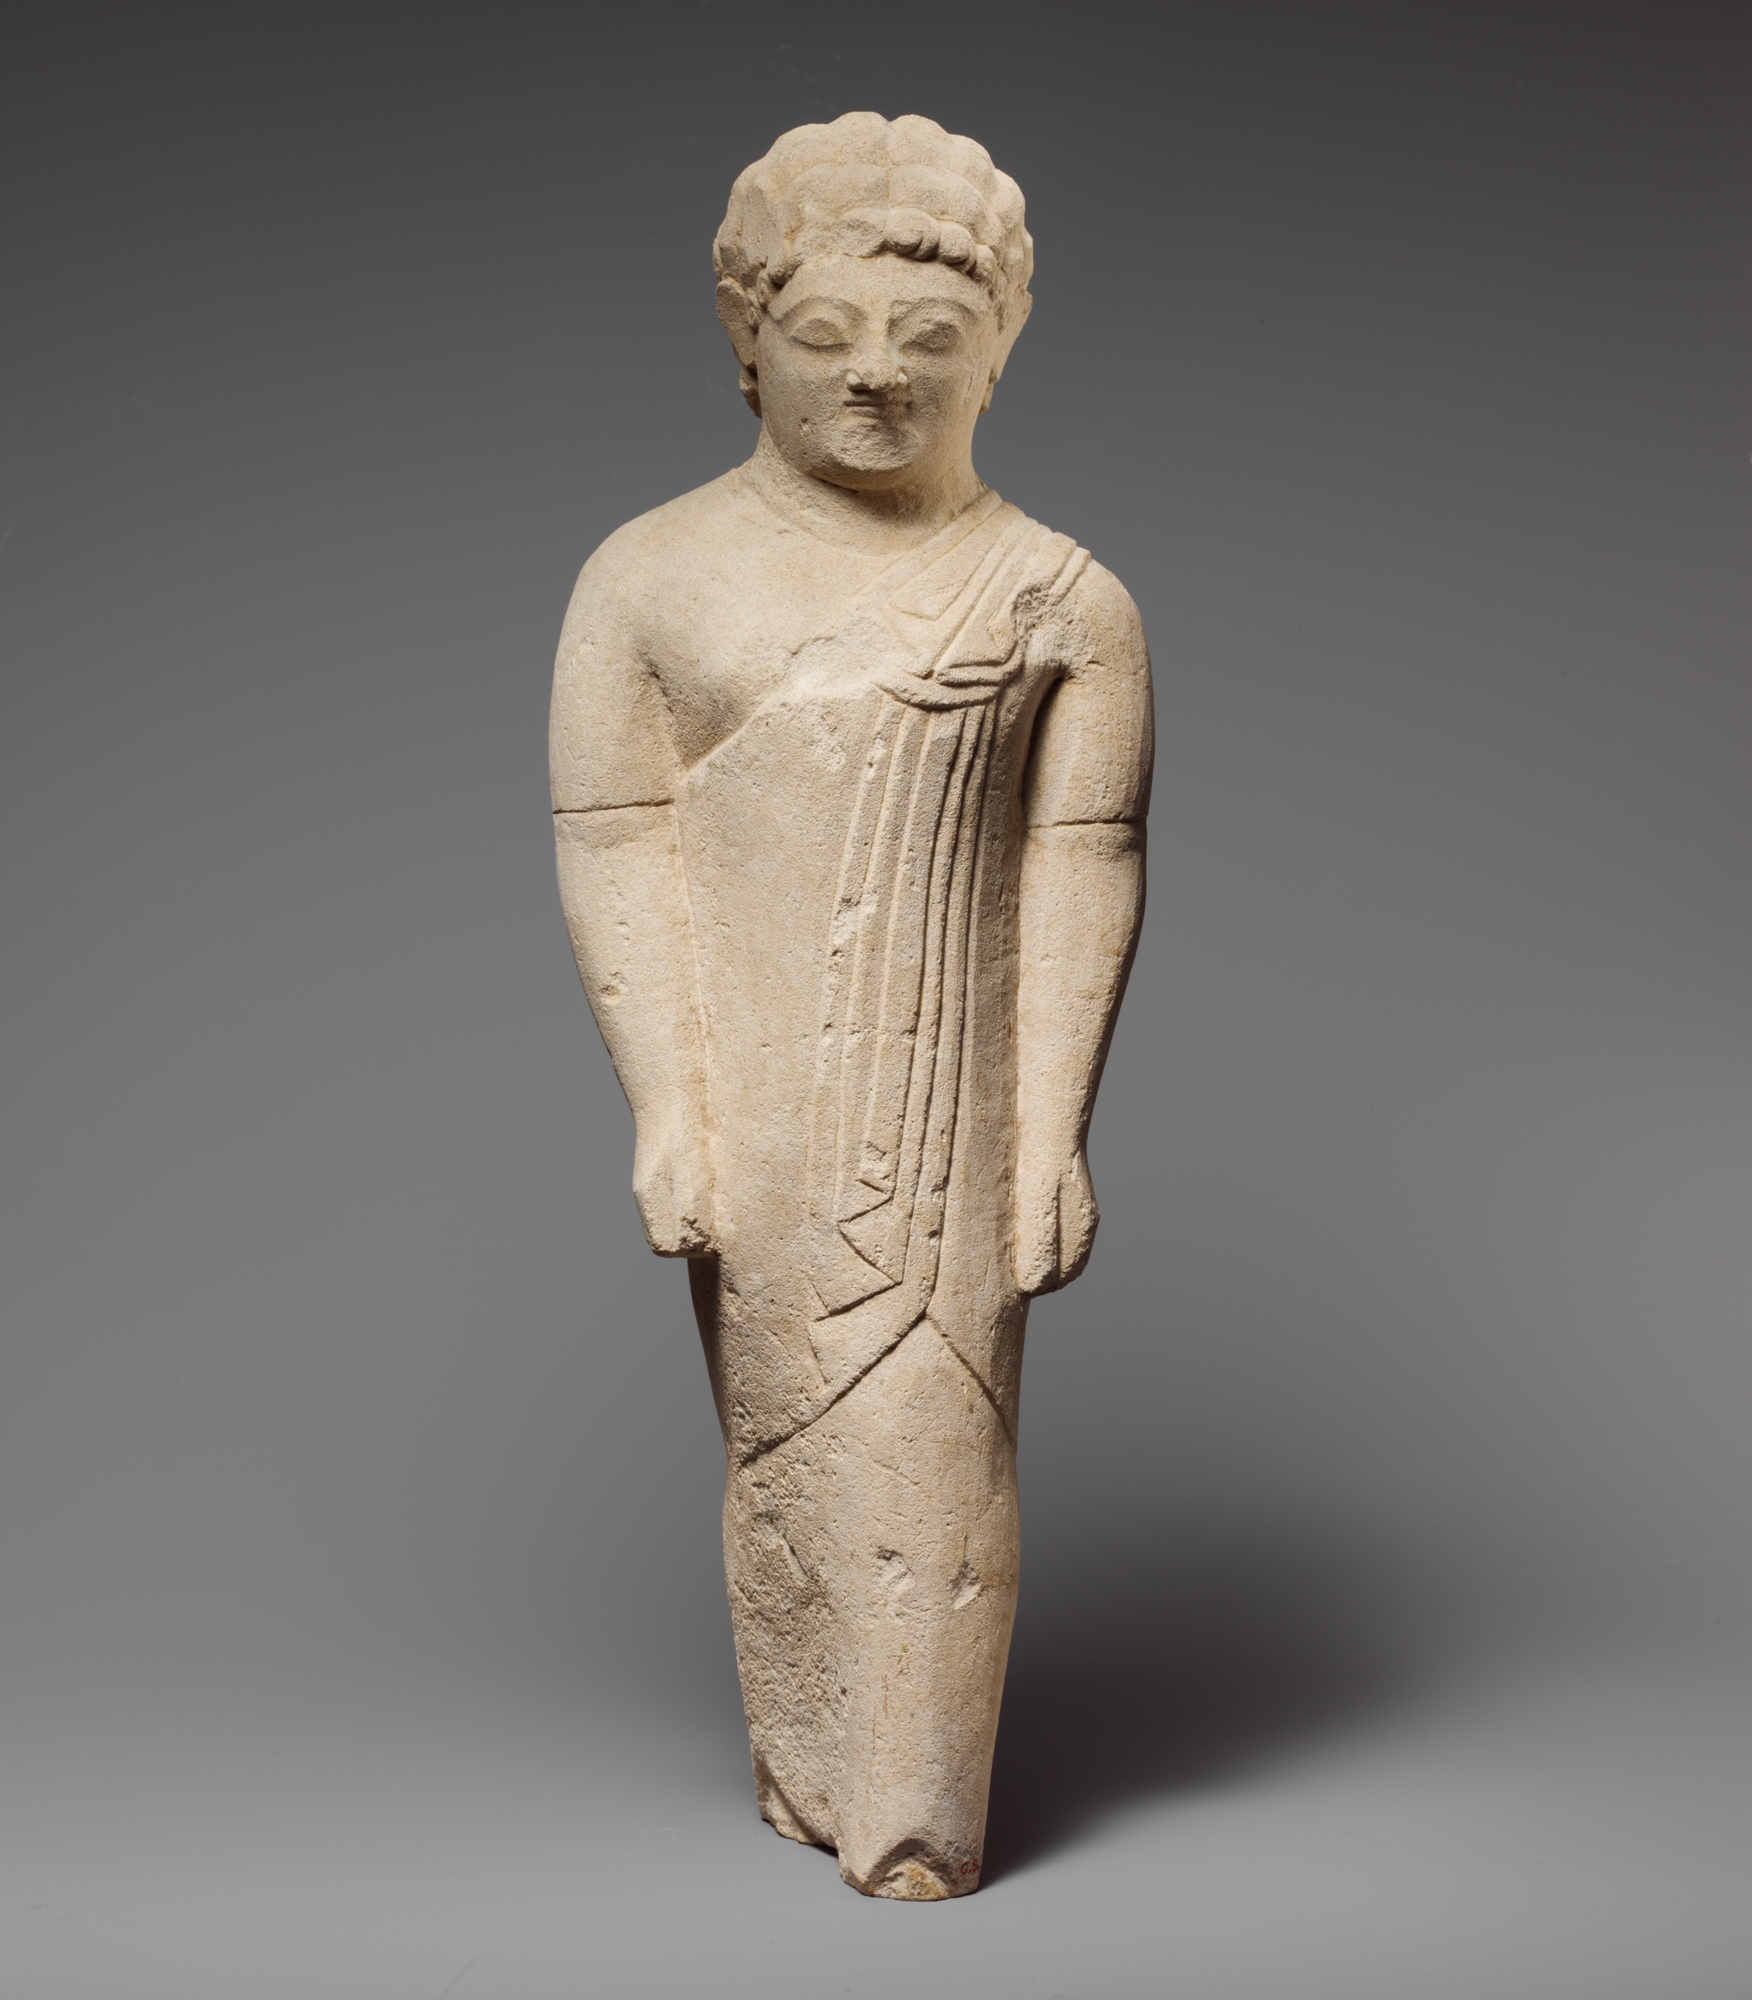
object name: statue of a votary, male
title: Limestone statuette of a beardless male votary in Greek dress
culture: cypriot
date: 534-501 BCE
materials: limestone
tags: men